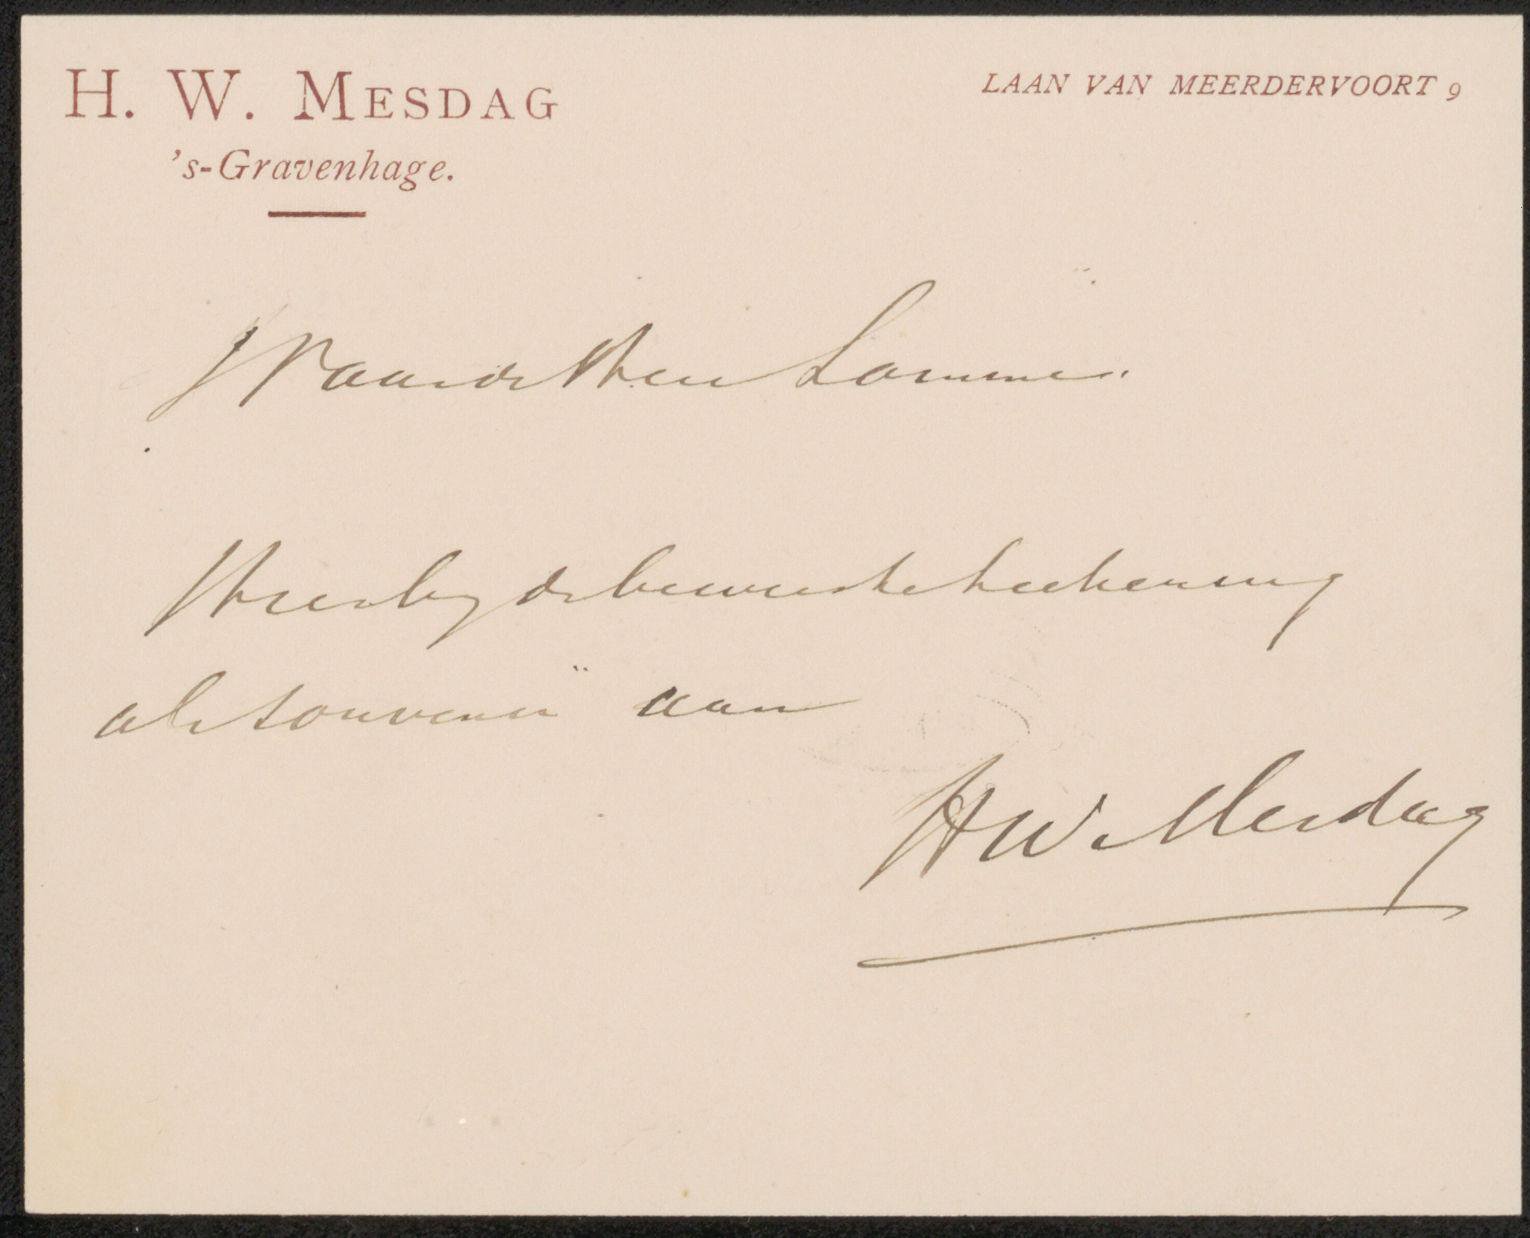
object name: letter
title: Brief aan Ary Johannes Lamme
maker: hendrik willem mesdag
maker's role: draughtsman, painter, print maker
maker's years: 1831-1915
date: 1841-1900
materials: cardboard, ink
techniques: pen, printing, writing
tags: dordrecht, print maker, draughtsman, ary johannes lamme, drawing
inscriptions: collector's mark: Lugt 2228